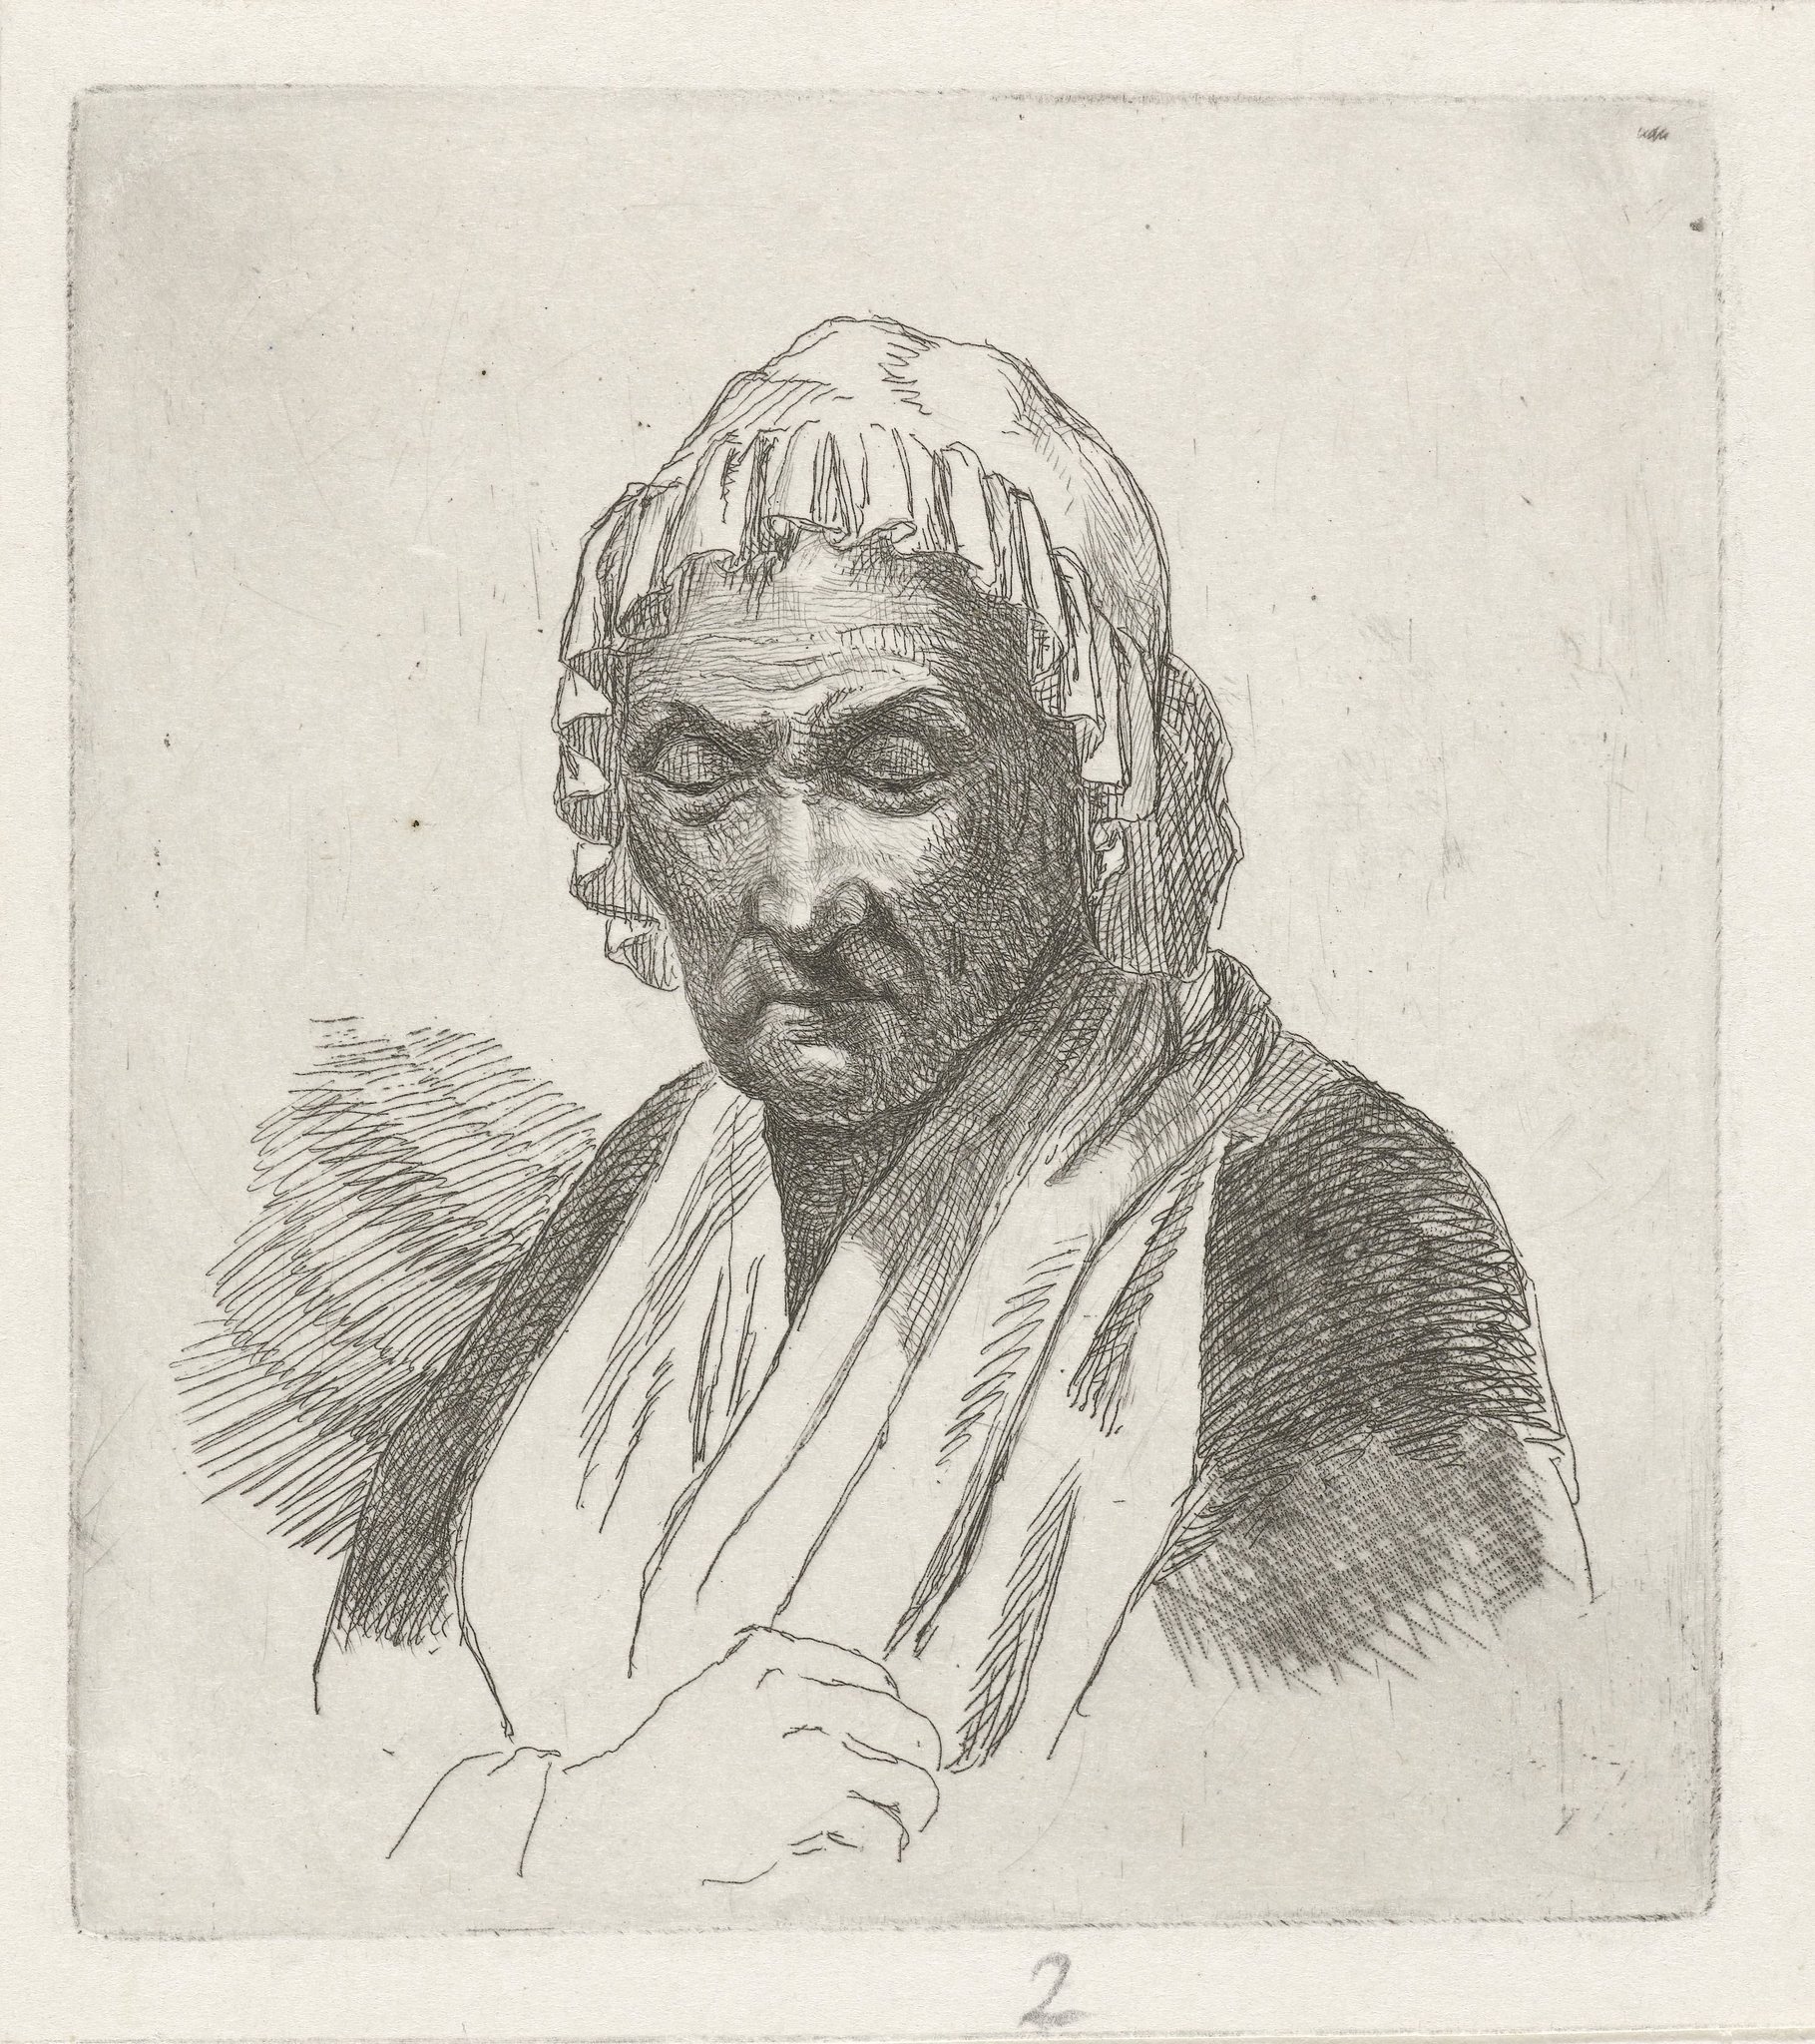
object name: print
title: Oudere vrouw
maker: david van der kellen (1804-1879)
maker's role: die cutter, draughtsman, print maker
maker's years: 1804-1879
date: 1814-1879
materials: paper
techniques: etching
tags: old woman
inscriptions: inscription: ‘2’, collector's mark: Lugt 2228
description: Portret van een onbekende oudere vrouw met een kapje op het hoofd en een sjaal om de schouders.